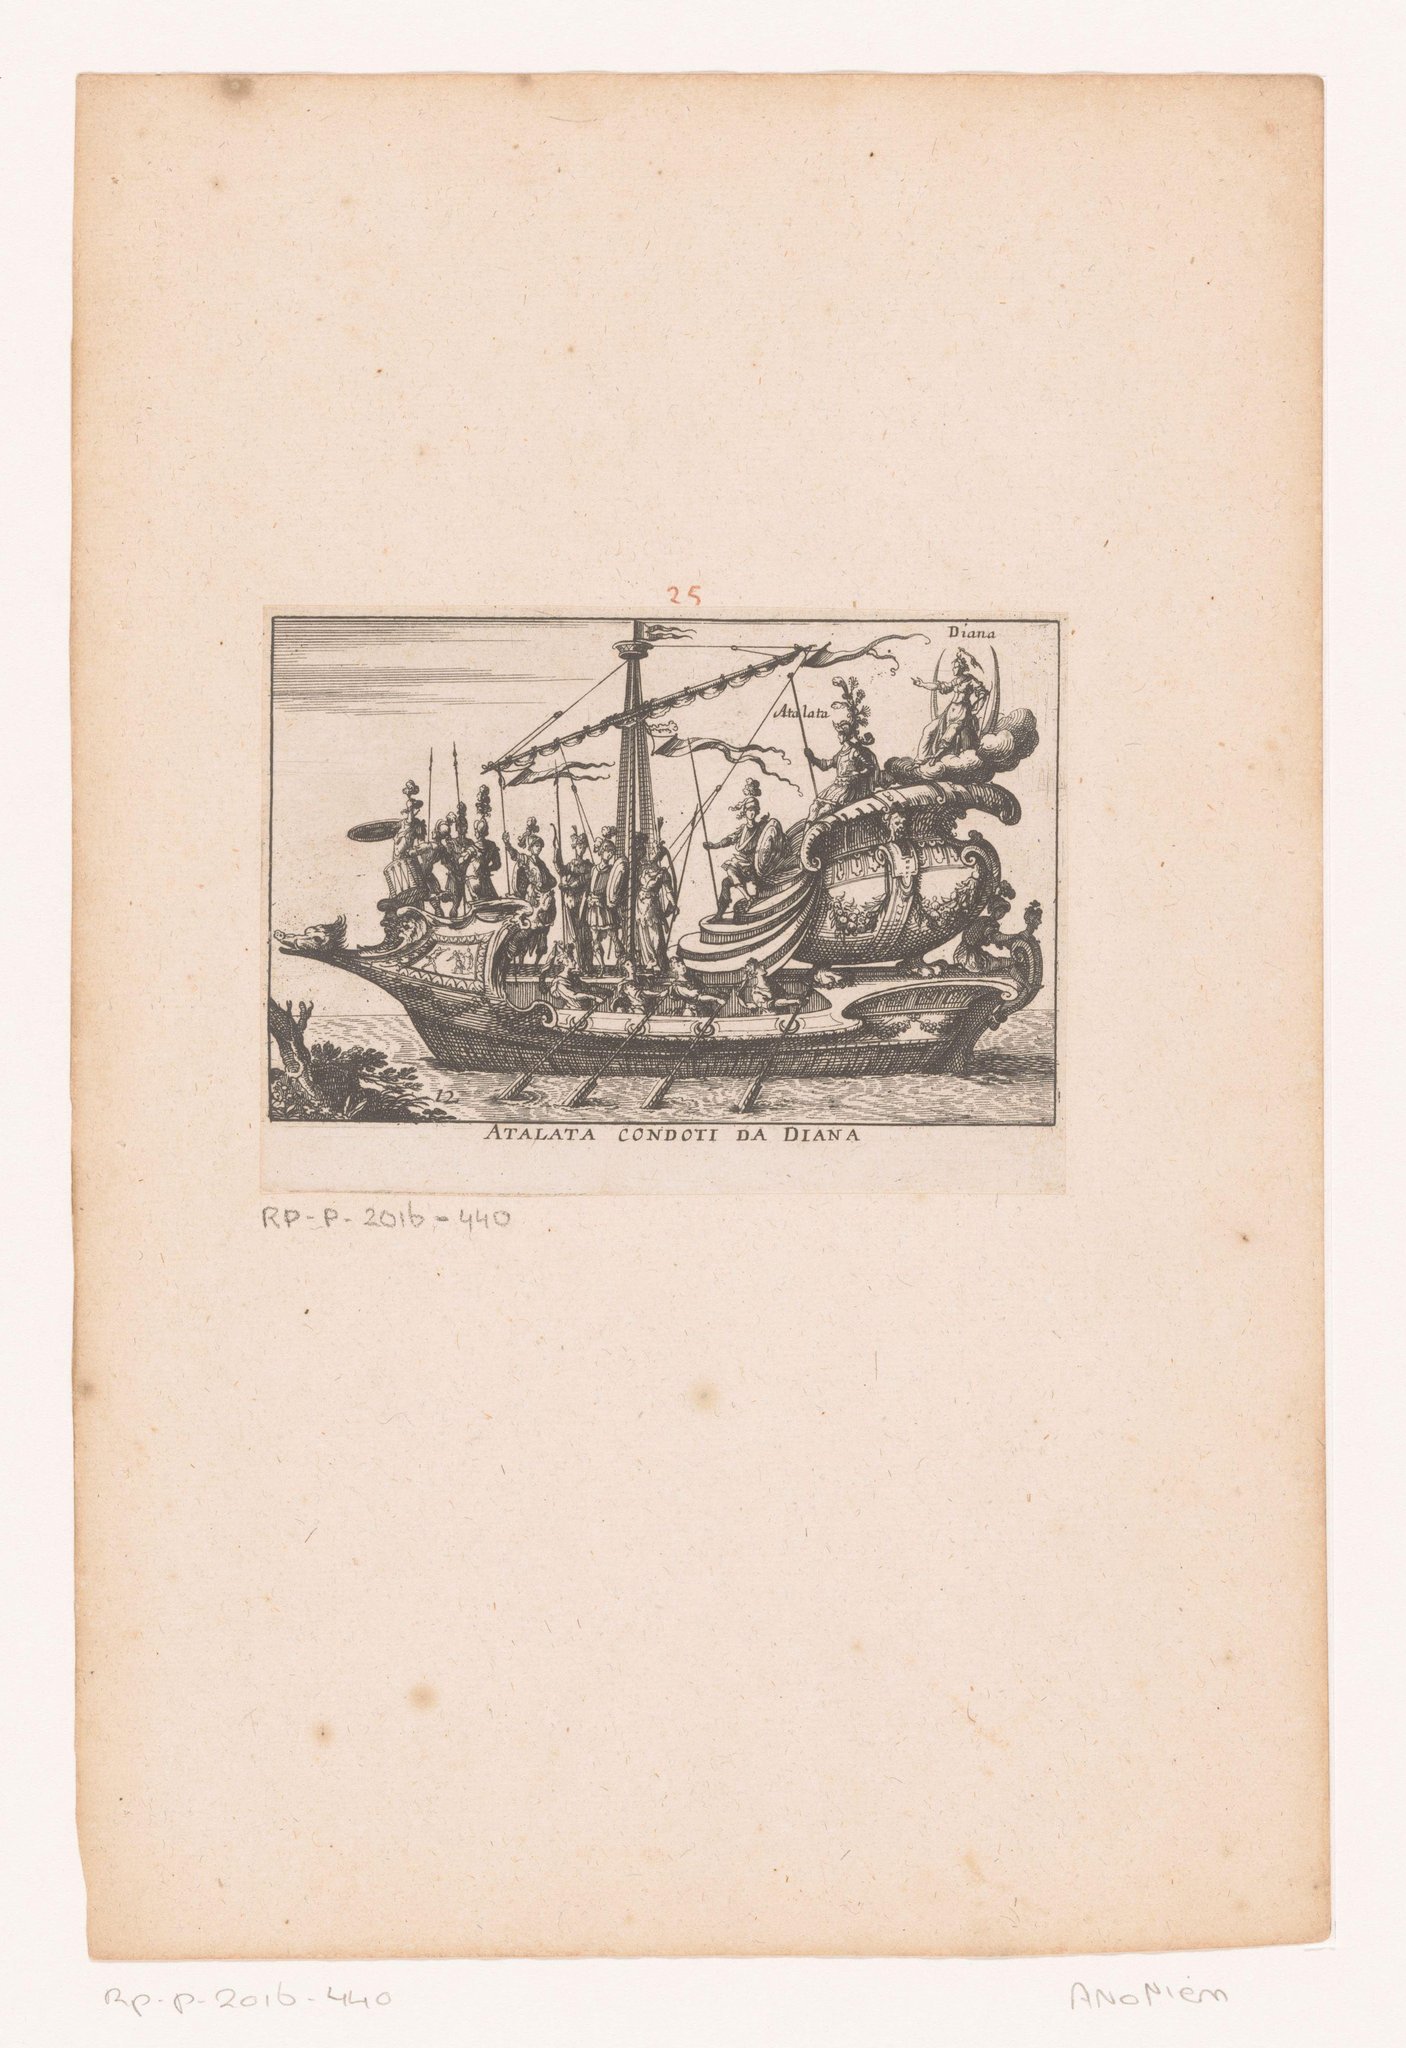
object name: print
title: Le Magnifique Carousel fait sur le fleuve de l'Arne à Florence pour le Mariage du grand Duc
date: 1624-1631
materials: paper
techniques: etching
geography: paris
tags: (story of) diana (artemis), ships (in general), the story of the argonauts: the quest for the golden fleece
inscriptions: number: ‘25’, collector's mark: Lugt 2228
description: Een schip met zwijnskop als boegbeeld, op het achtersteven zitten Atalanta en Diana.